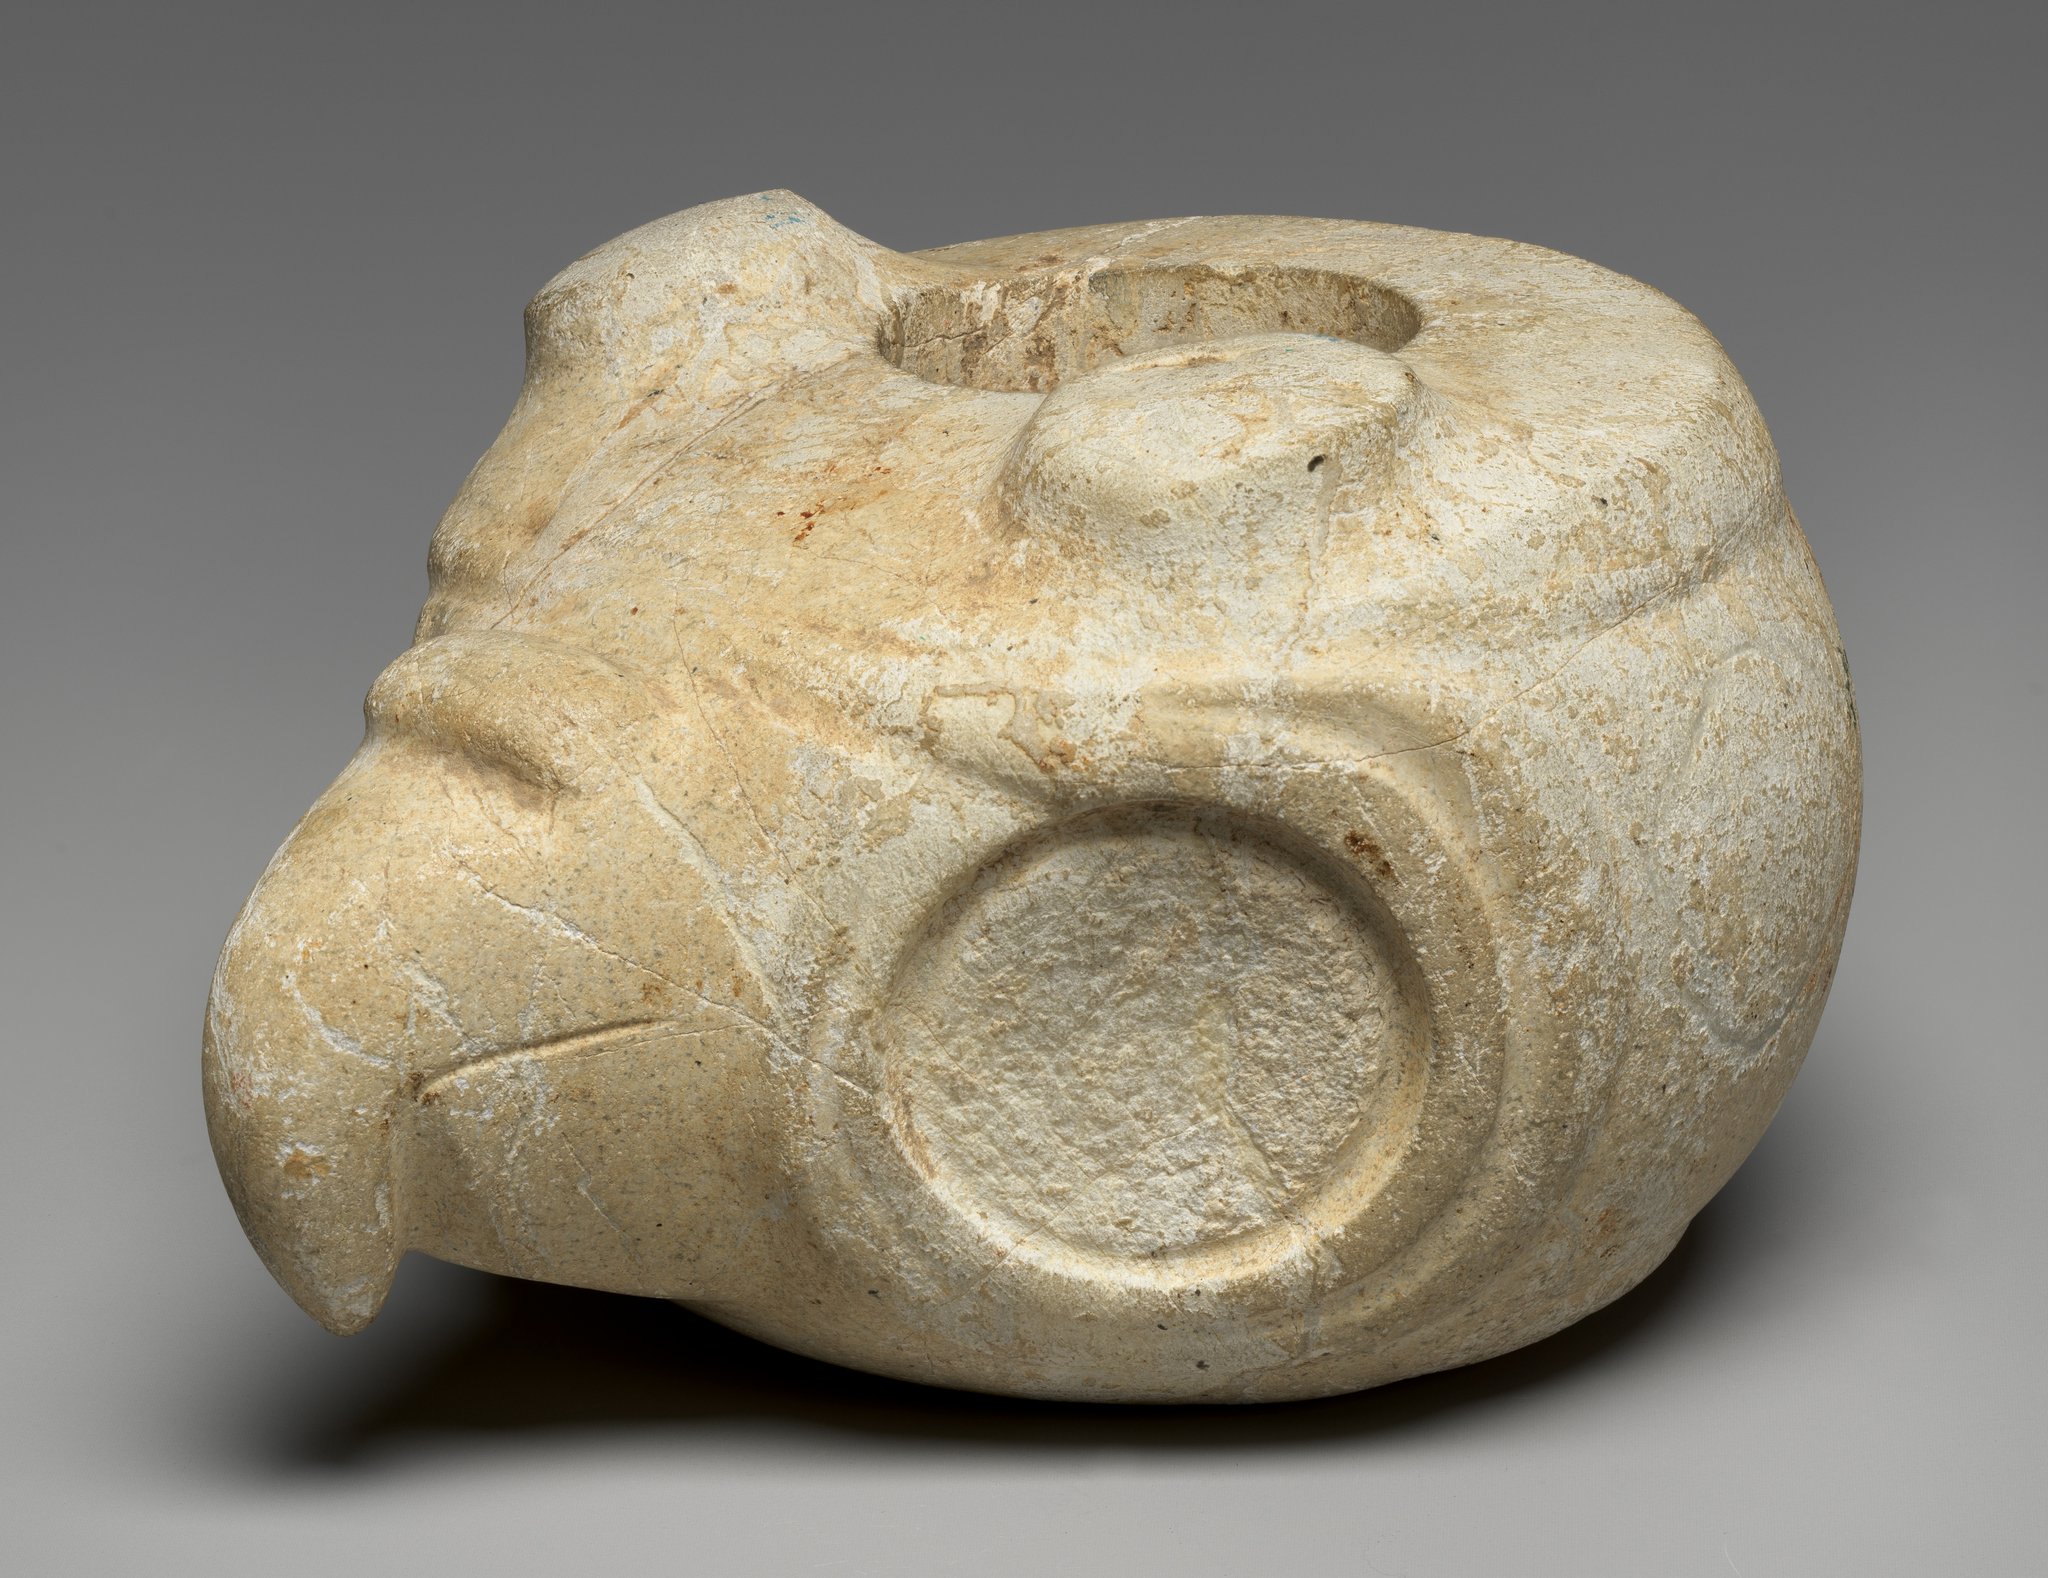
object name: mace head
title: Owl Mace Head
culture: atlantic watershed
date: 1-500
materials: stone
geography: costa rica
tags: owls